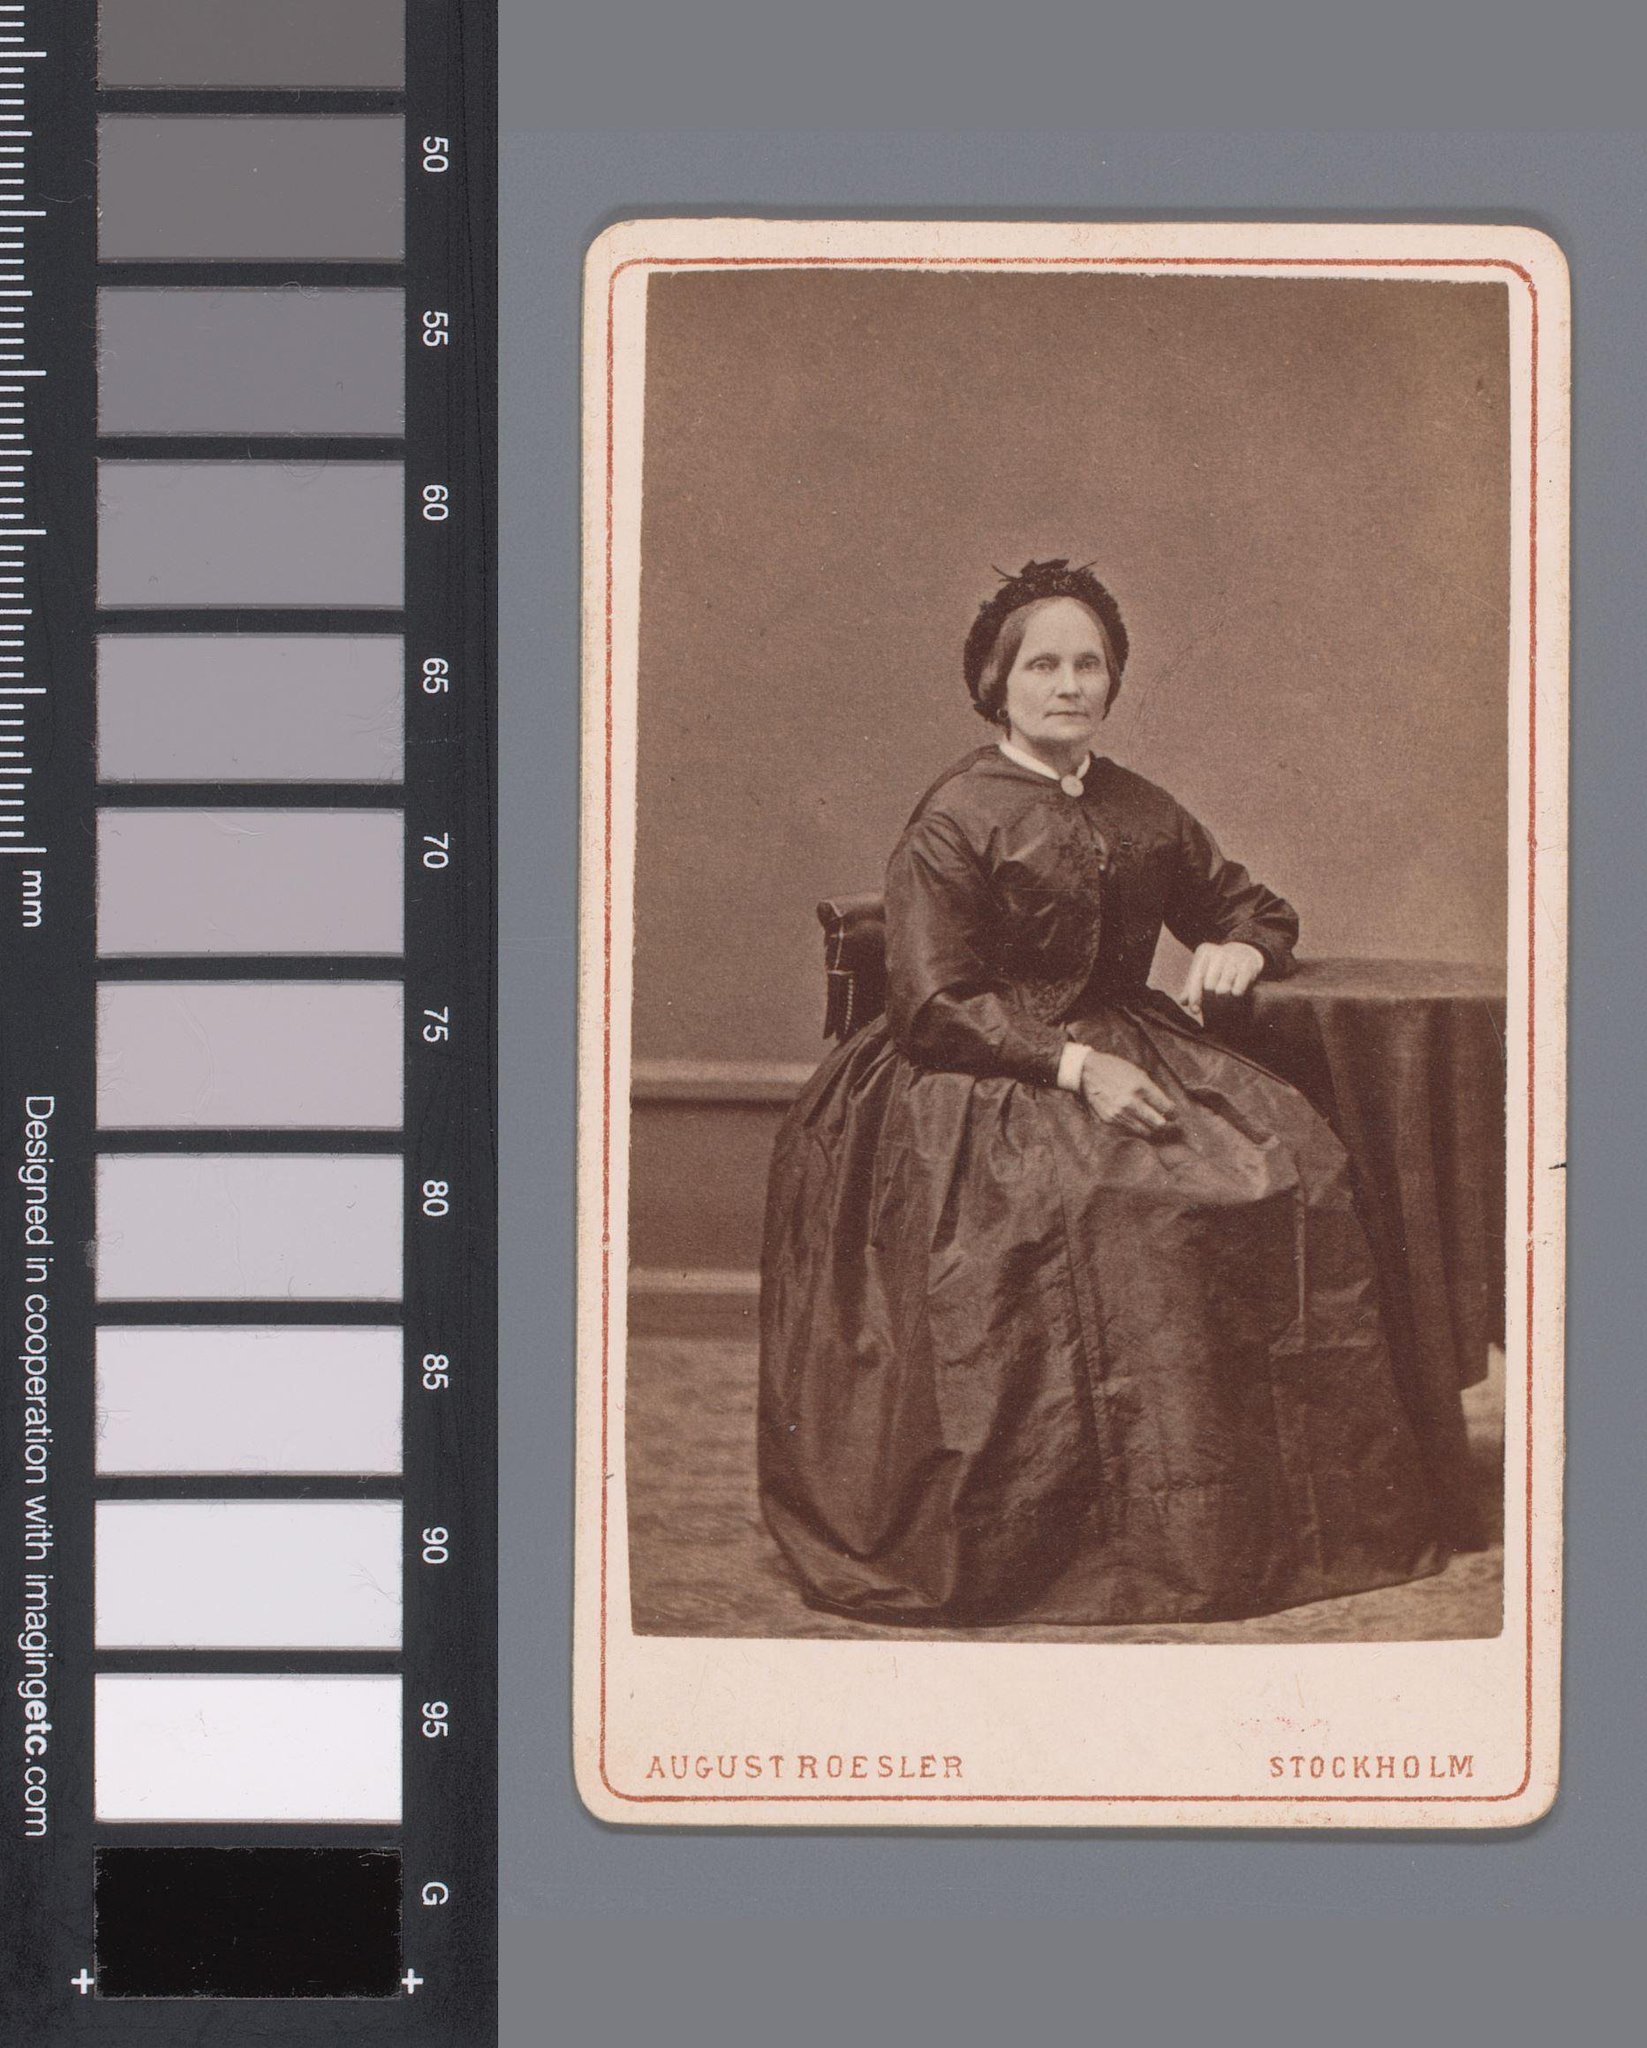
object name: photograph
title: Portret van een onbekende vrouw, zittend aan een tafel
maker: august roesler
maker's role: fotograaf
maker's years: 1837-1896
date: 1862-1896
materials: cardboard, paper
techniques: albumen print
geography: stockholm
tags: sitting figure - aa - female human figure, historical persons - bb - woman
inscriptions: inscription: ‘AUGUST ROESLER/ Fotografisk Atelier/ STOCKHOLM/ 23, Drottninggatan 23./ Plåten förvaras för efterbeställning.’